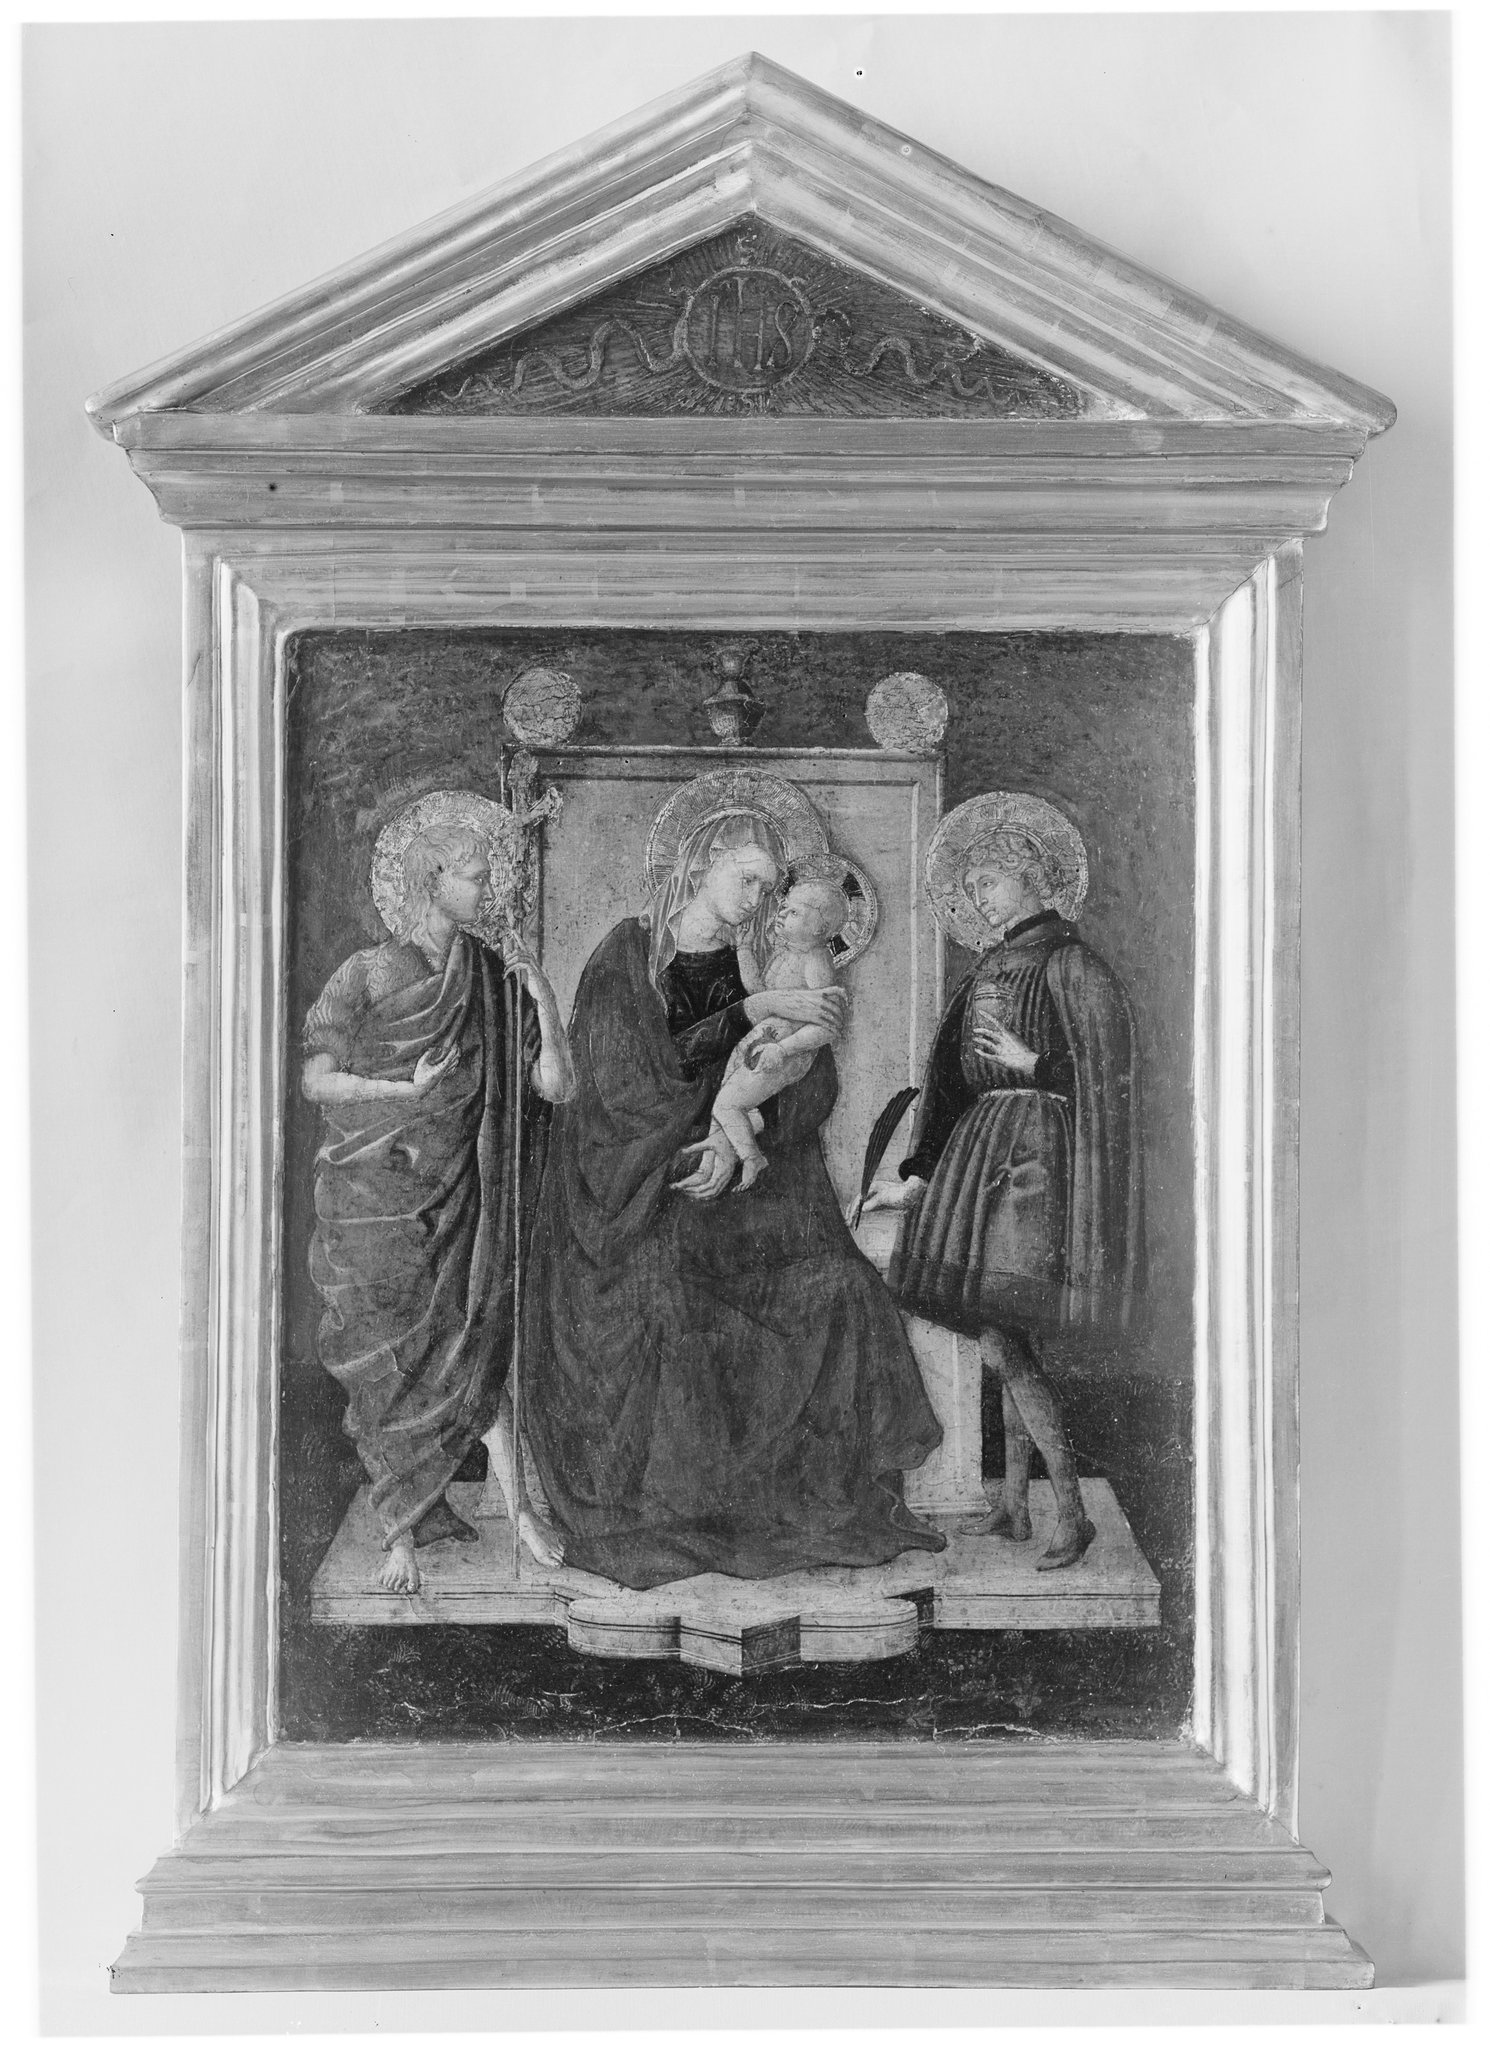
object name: painting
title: Madonna and Child Enthroned with Saint John the Baptist and Another Saint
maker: italian (florentine) painter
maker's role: artist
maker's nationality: italian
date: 1425-1449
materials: gold, paint, wood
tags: madonna and child,saint john the baptist,saints